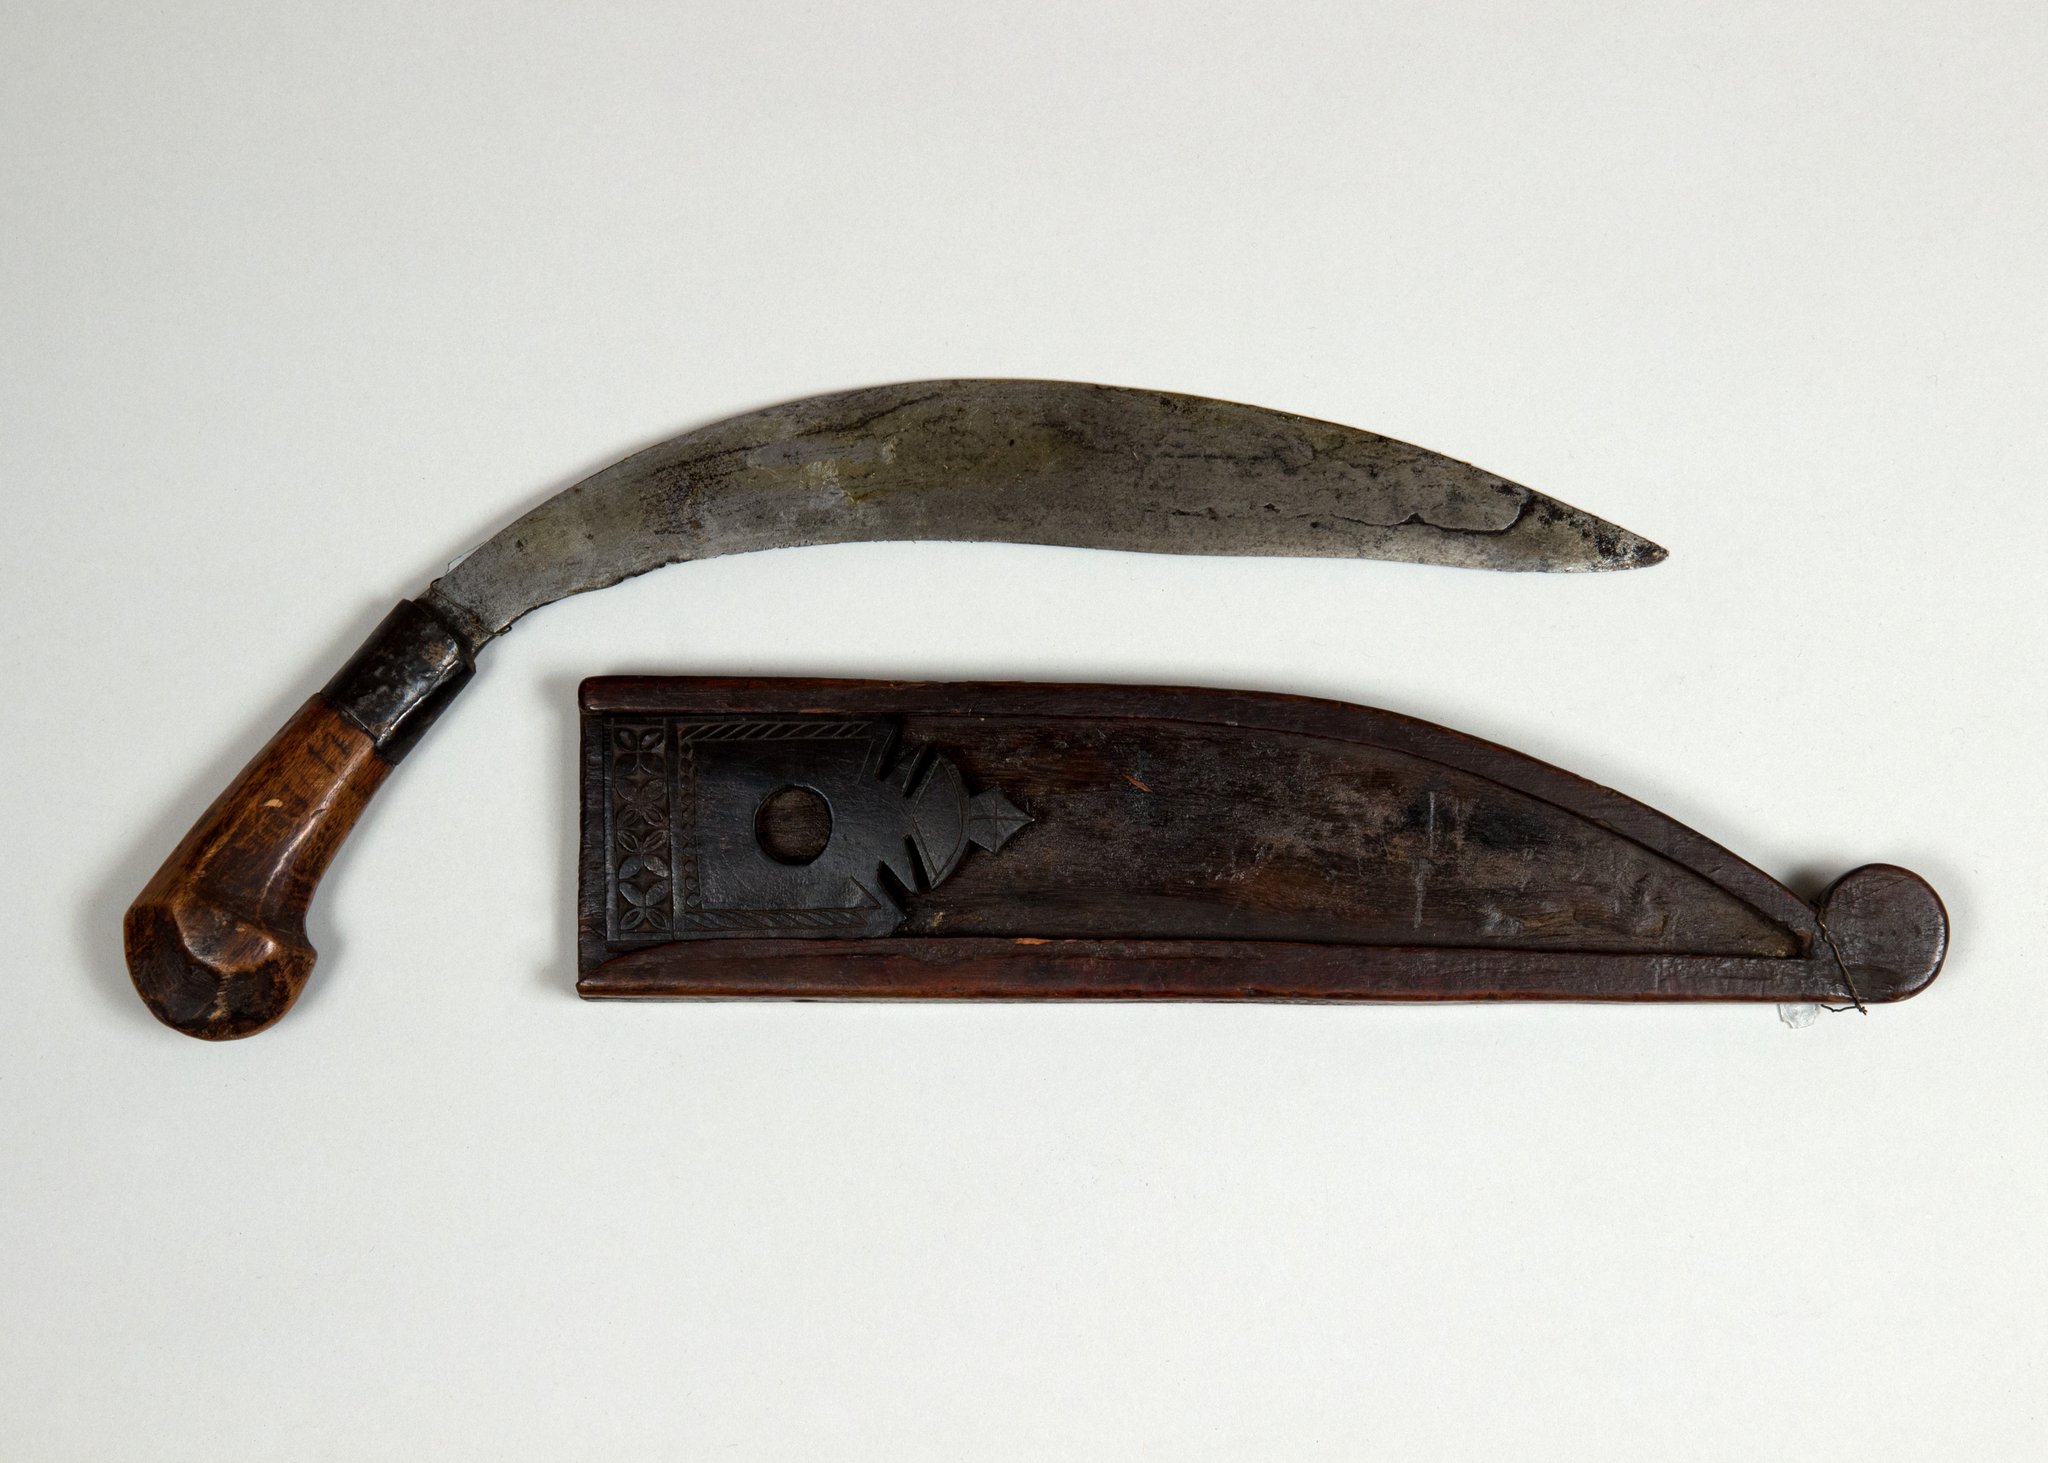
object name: knife with sheath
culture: philippine, moro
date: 1701-1900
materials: steel, wood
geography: philippines